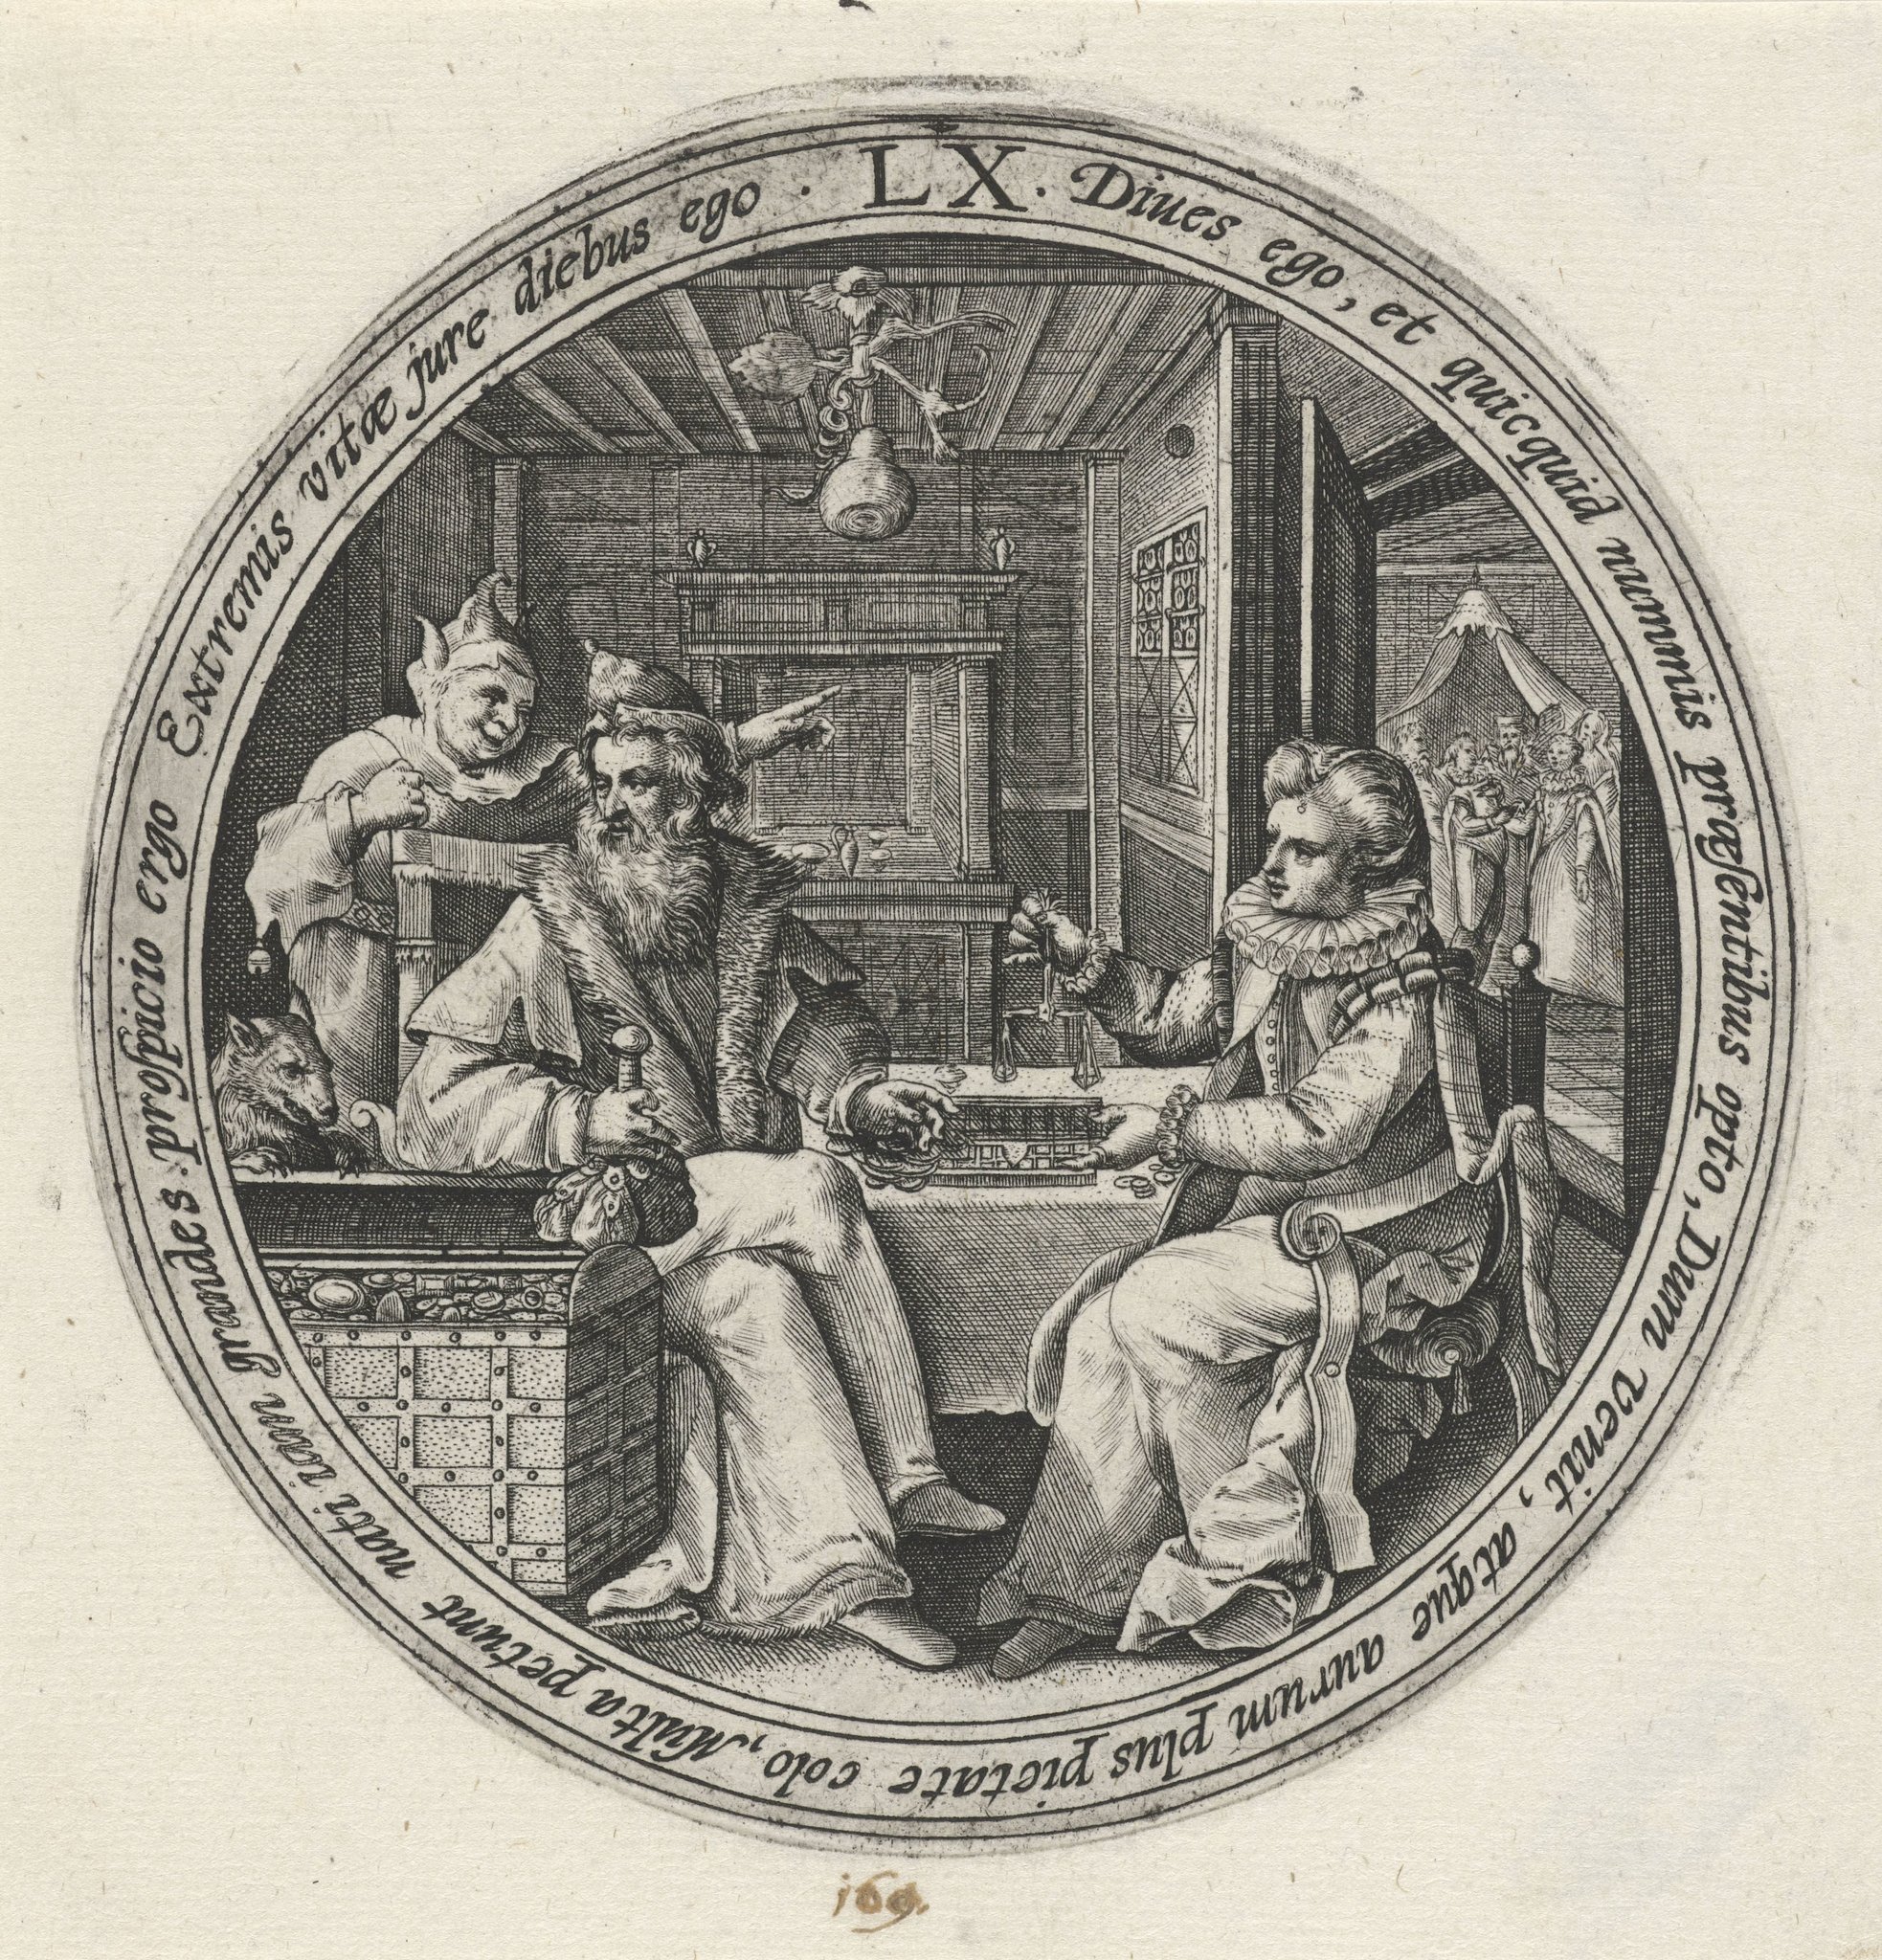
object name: print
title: De mens op zestigjarige leeftijd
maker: crispijn van de passe (i)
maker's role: draughtsman, print maker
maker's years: 1564-1637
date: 1574-1637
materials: paper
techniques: engraving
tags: human life and its ages (young, adult, old, etc.), court jester, court fool, old man, weighing gold or money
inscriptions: number: ‘169’, collector's mark: Lugt 2161, collector's mark: Lugt 2228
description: Vertrek met een echtpaar aan een tafel. De vrouw weegt goud en naast de man staat een schatkist. Links op de achtergrond een nar en een wolf. In de omlijsting een randschrift in het Latijn. Zesde prent uit een serie van tien met de tien leeftijden van de mens.